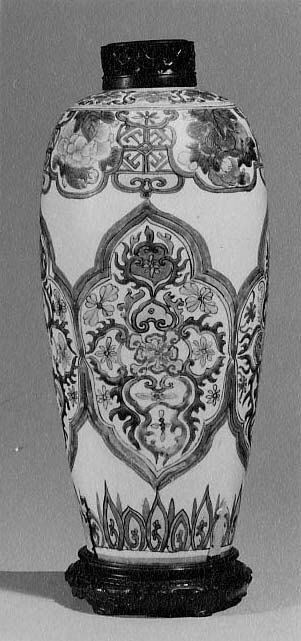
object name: vase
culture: chinese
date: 1662-1722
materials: enamel, porcelain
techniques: painting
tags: flowers